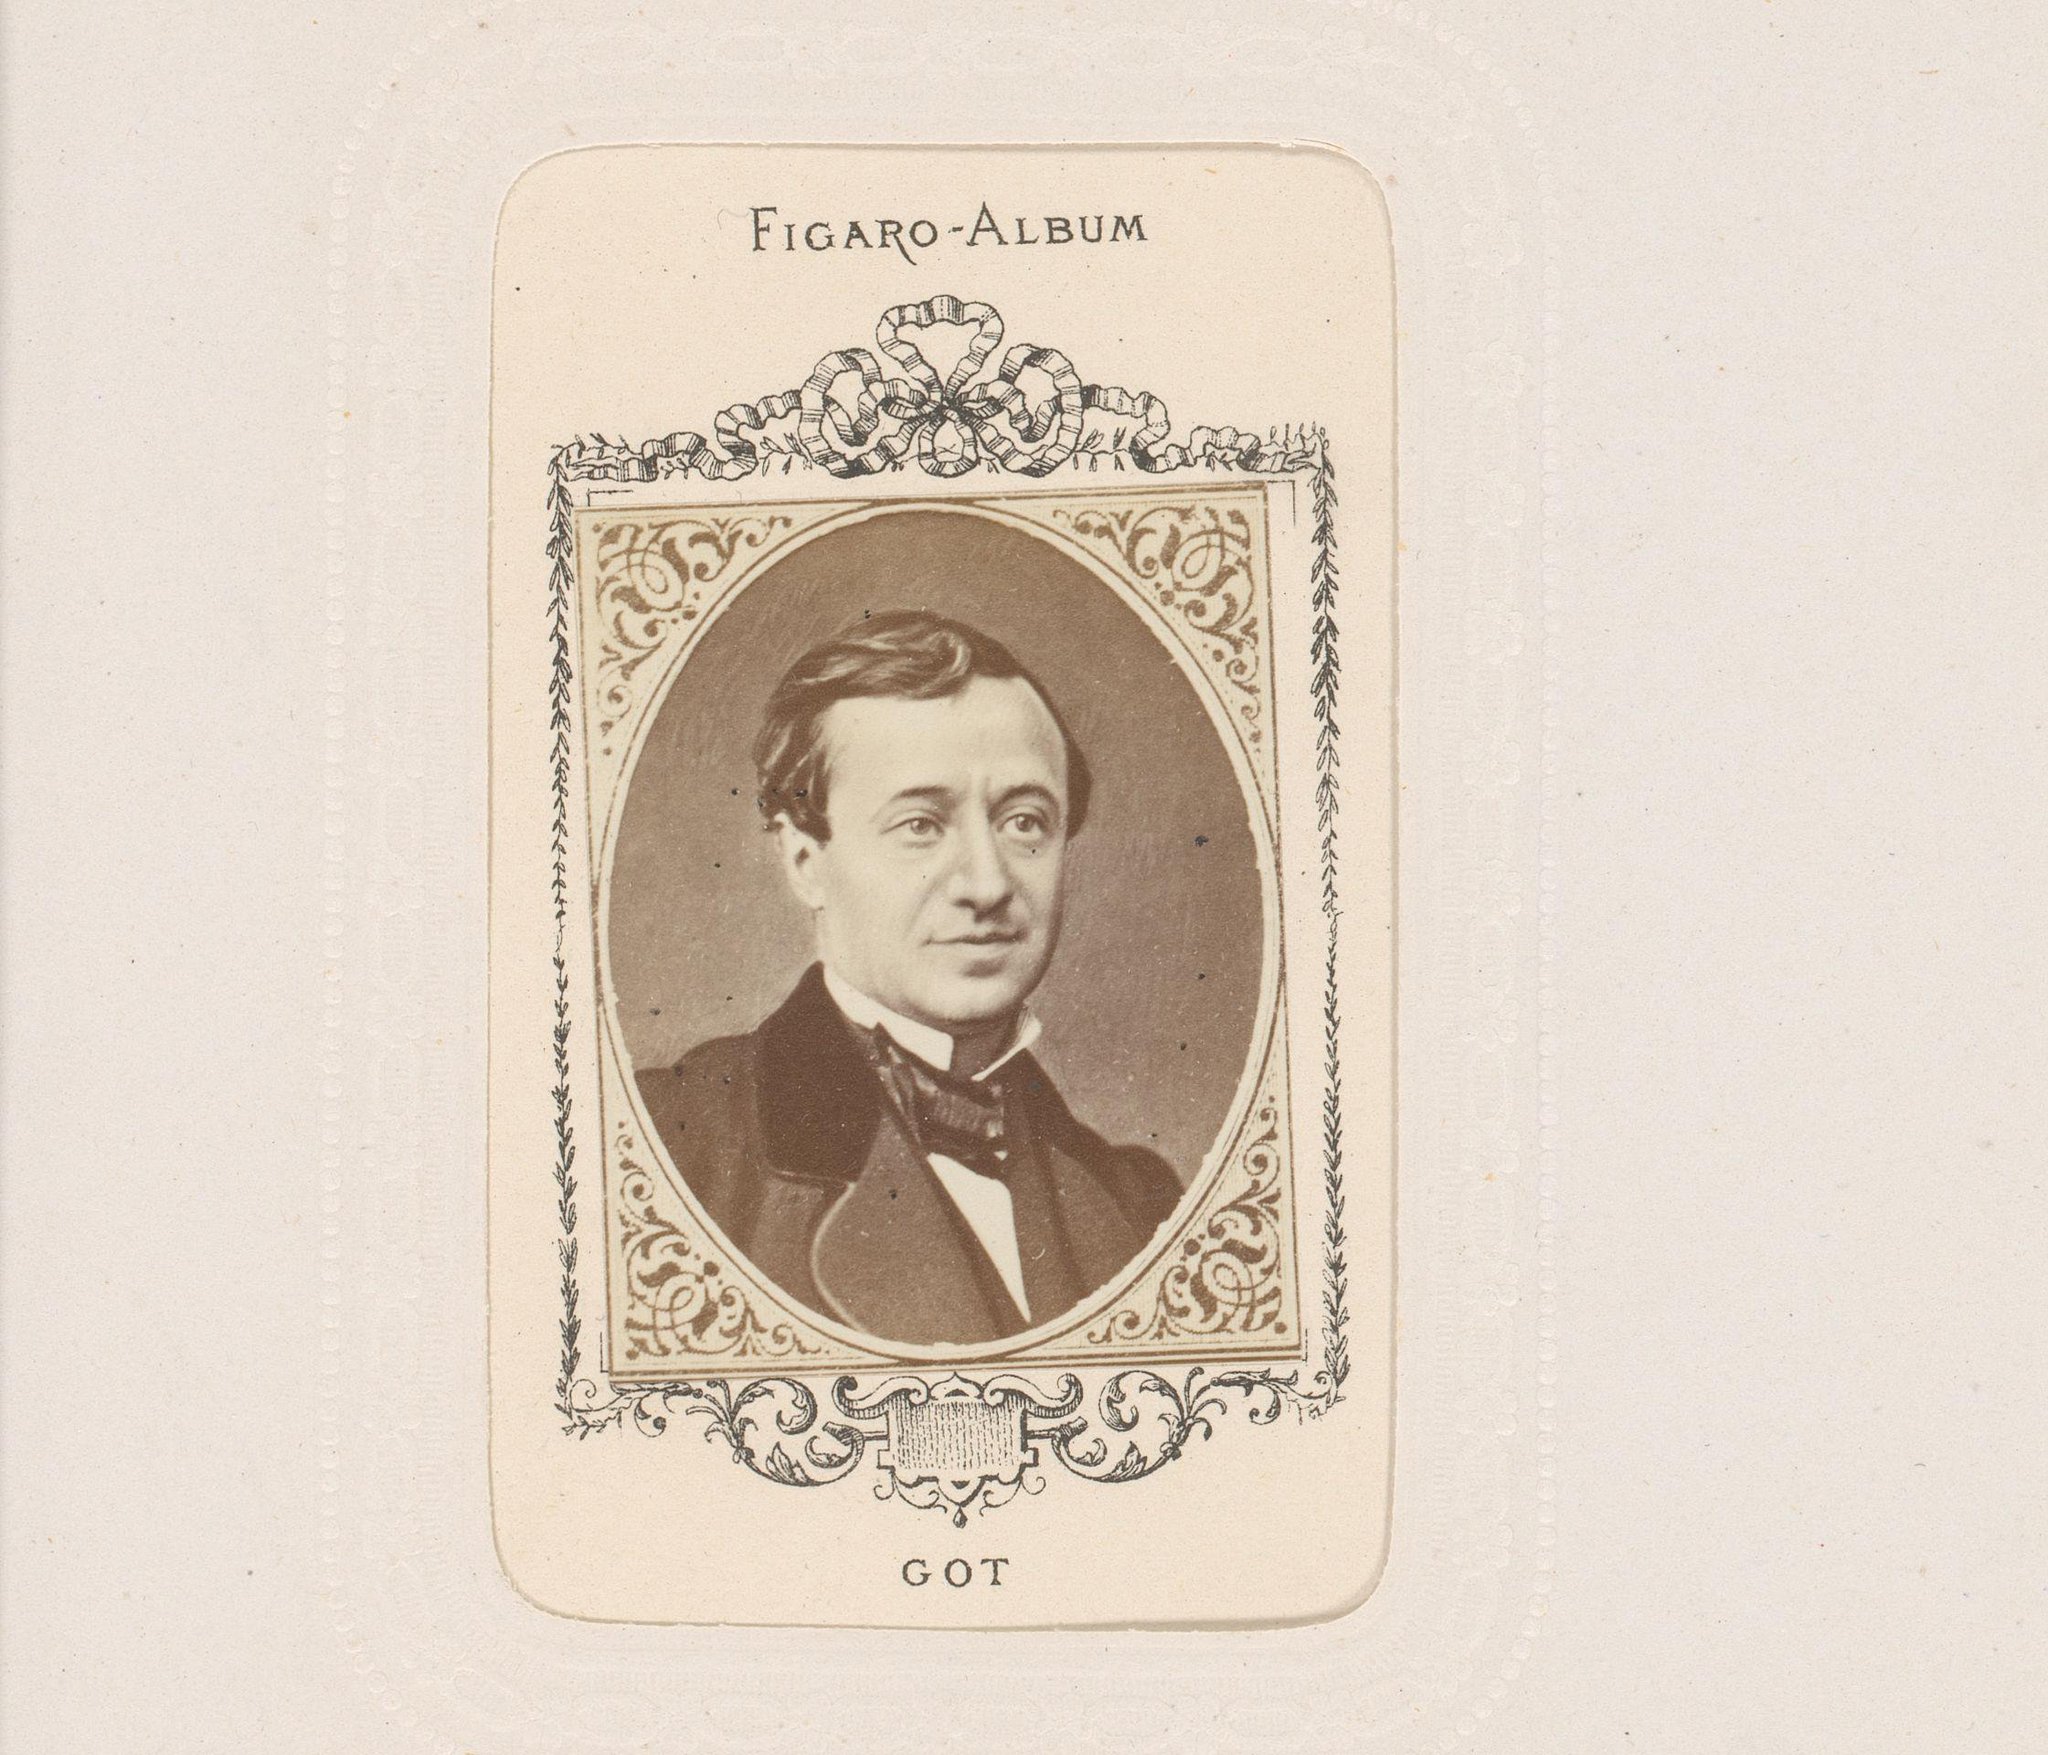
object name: carte de visite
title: Fotoreproductie van een portret van Edmond Got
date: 1860-1900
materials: cardboard, photographic support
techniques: albumen print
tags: historical persons, portrait of actor, actress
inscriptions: inscription: ‘Figaro-Album/ Got/ d'après Franck Phot.’